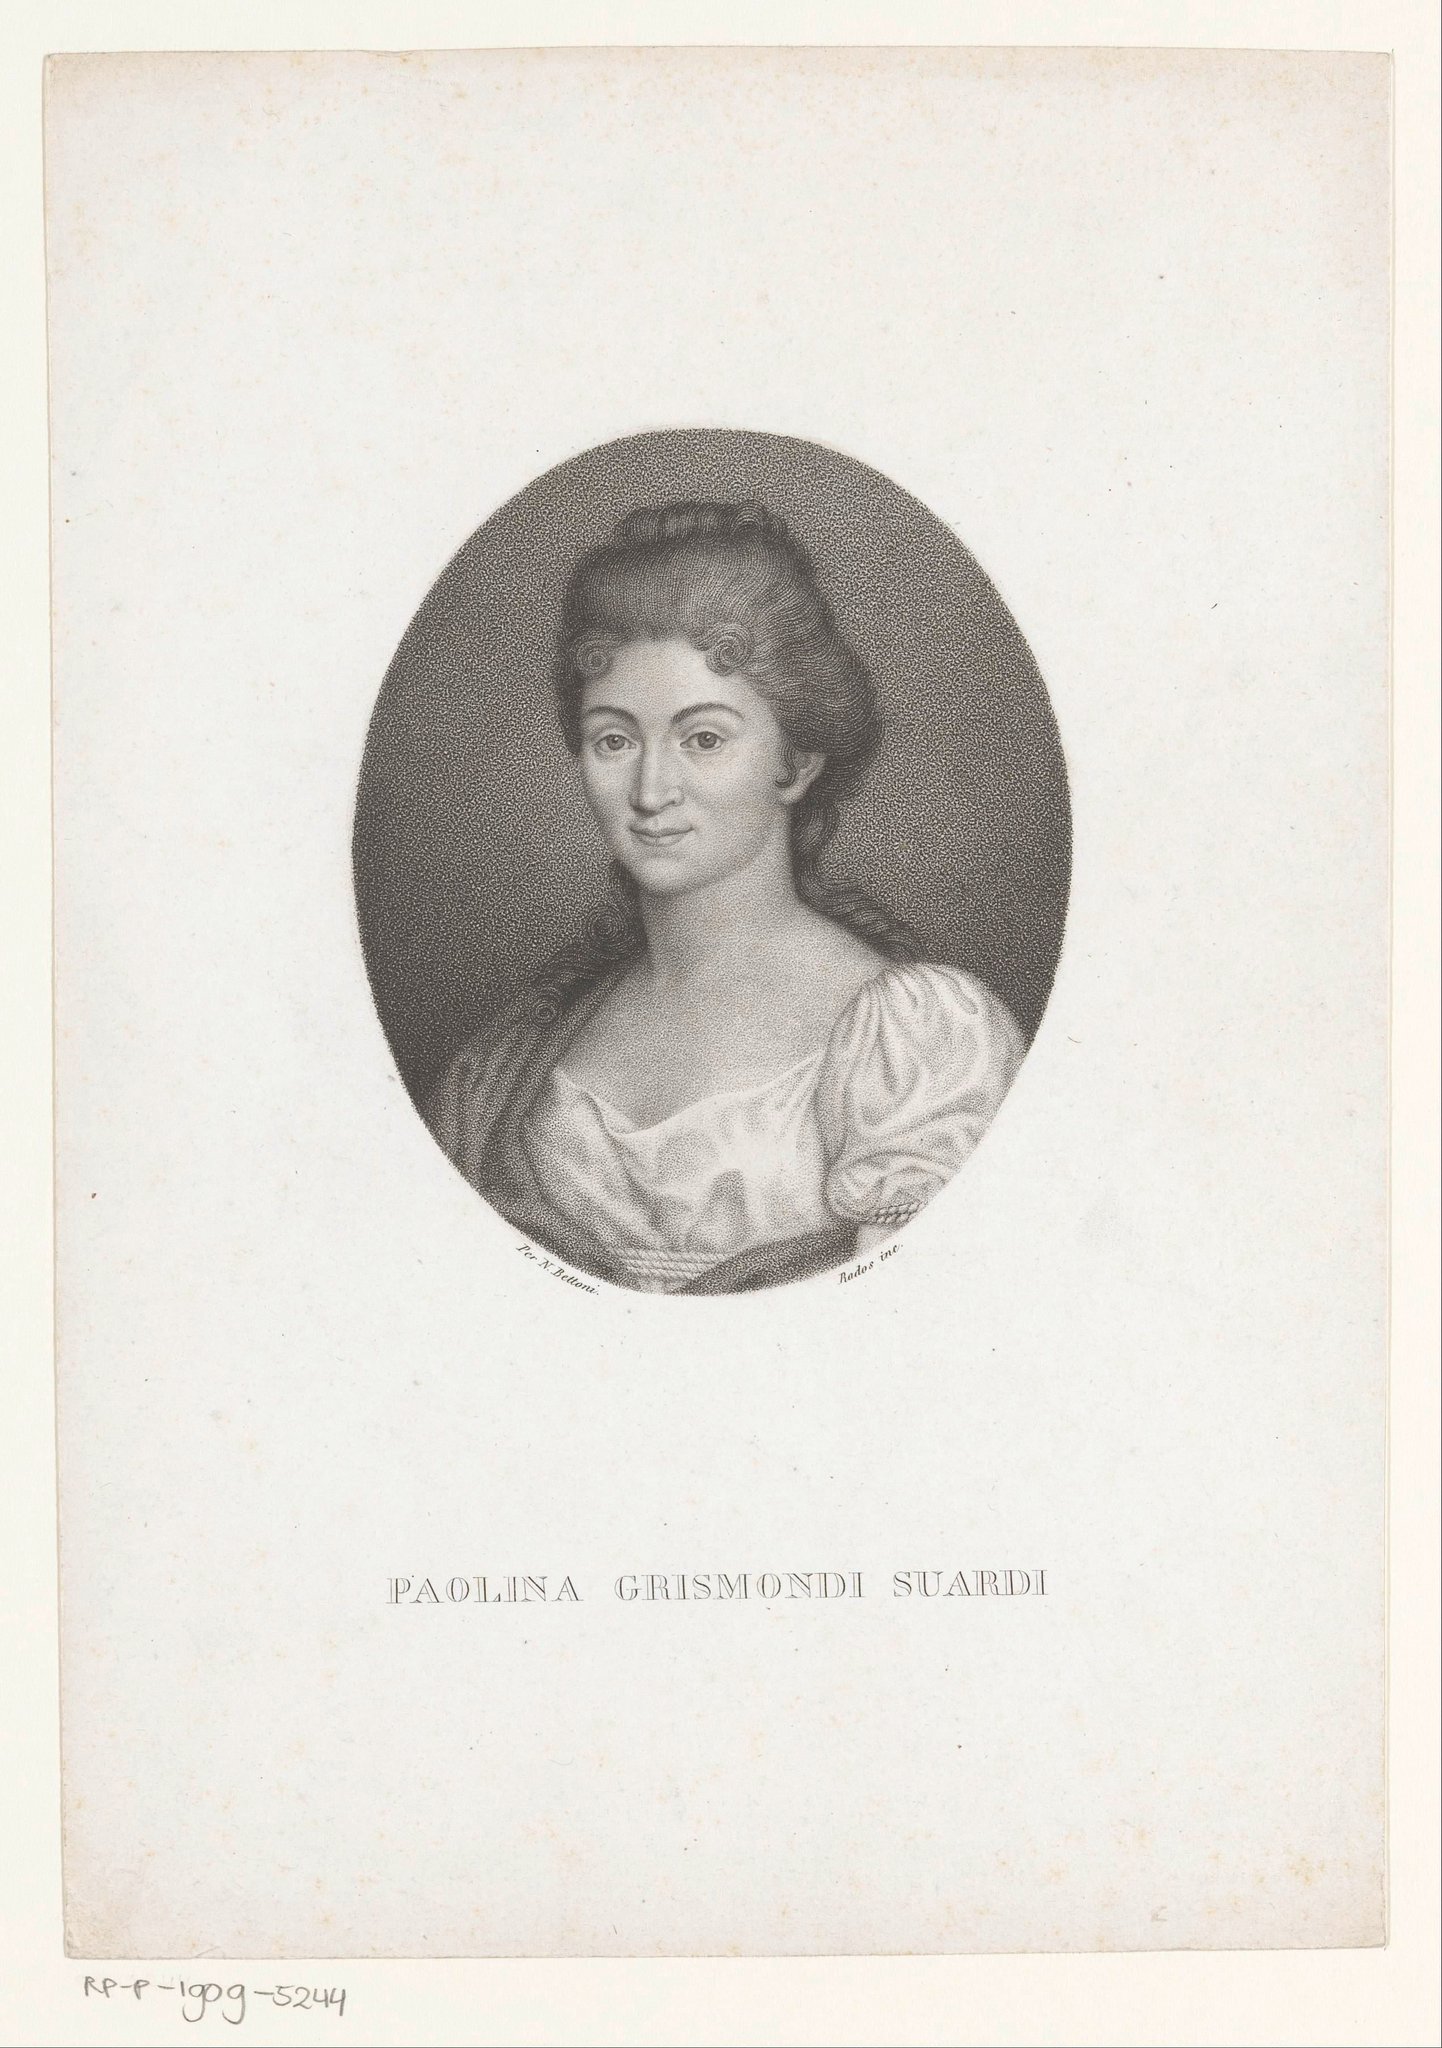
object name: print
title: Portret van dichteres Paolina Secco Suardi, pseudoniem Lesbia Cidonia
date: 1783-1840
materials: paper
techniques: stippling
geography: italy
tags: historical persons - bb - woman, portrait of a writer, writer, poet, author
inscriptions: collector's mark: Lugt 2228